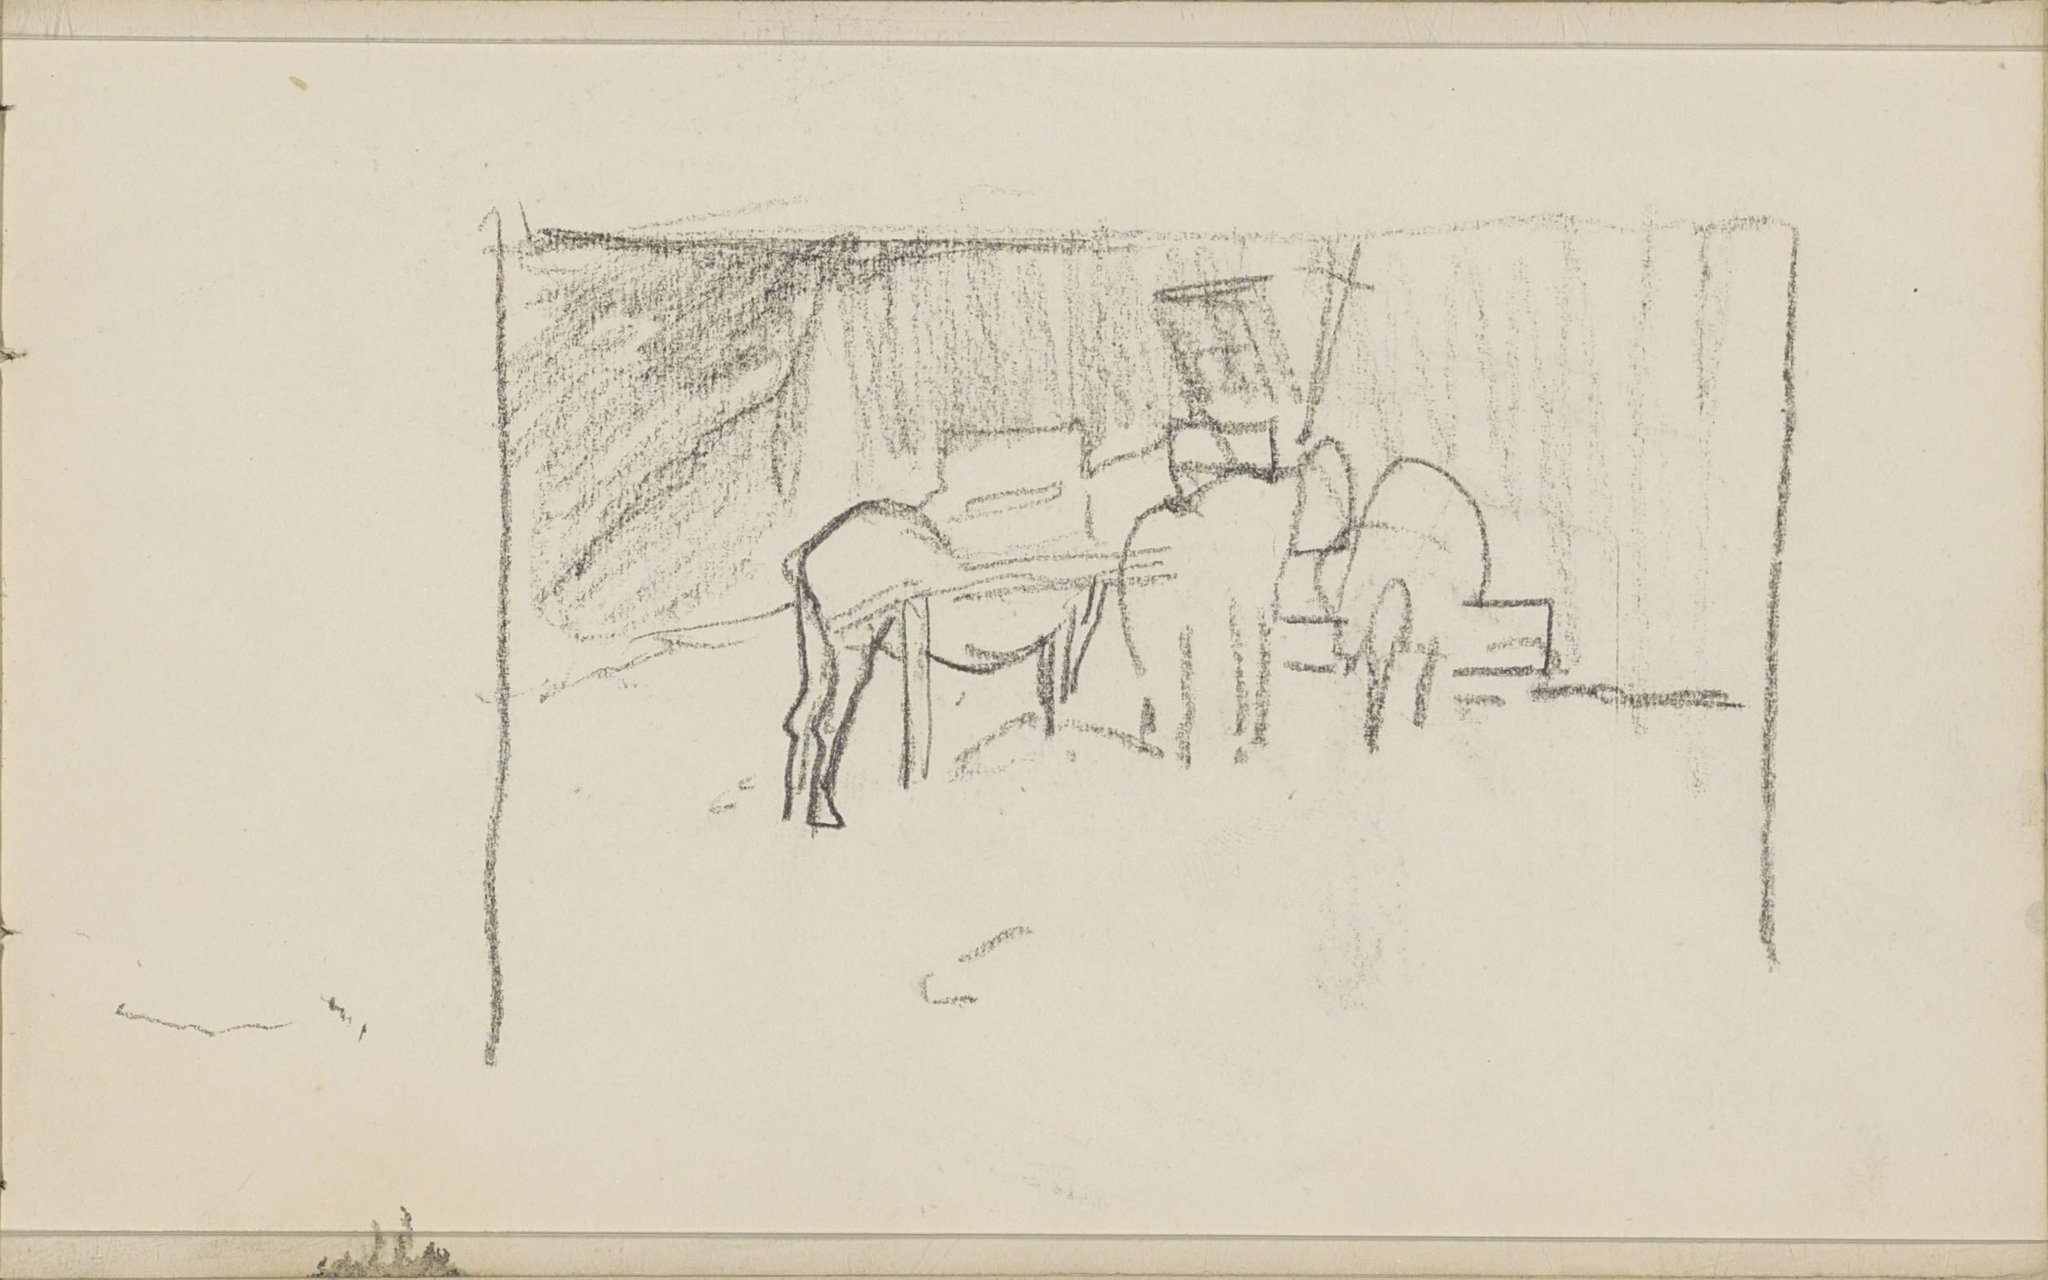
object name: sketchbook leaf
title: Dieren bij een voederplaats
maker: anton mauve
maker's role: draughtsman, painter, print maker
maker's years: 1838-1888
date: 1848-1888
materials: chalk, paper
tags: animals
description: Blad 28 recto uit een schetsboek met 42 bladen.